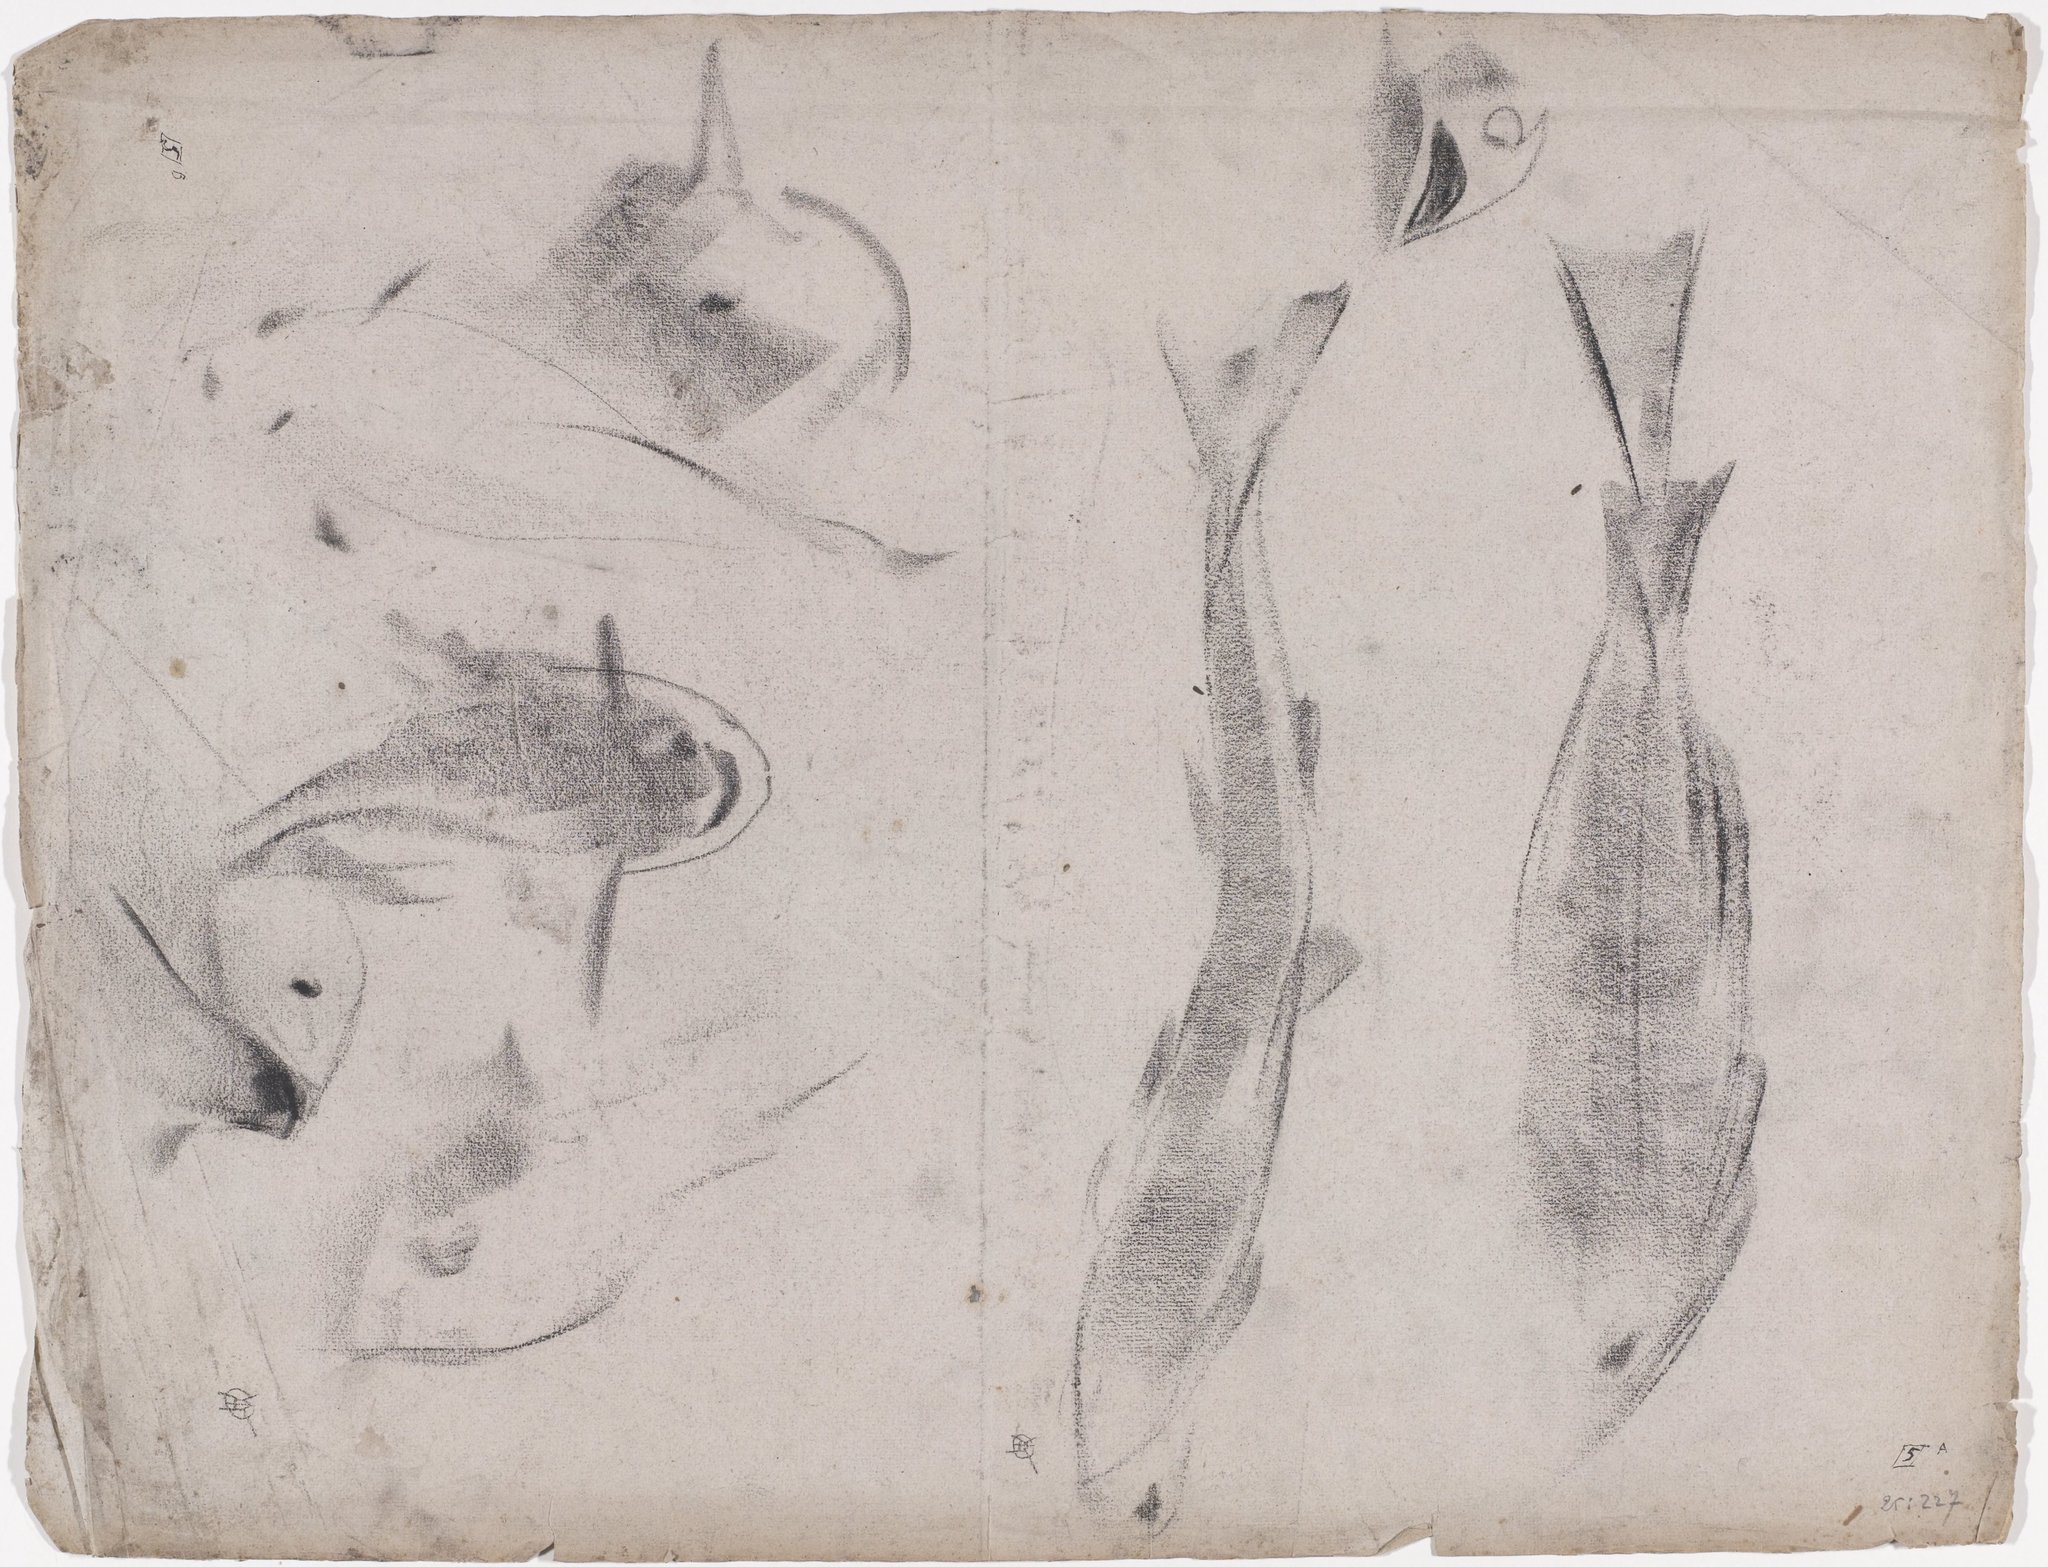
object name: drawing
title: Schetsblad met studies van karpers, van voren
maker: gerrit willem dijsselhof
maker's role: designer, draughtsman, print maker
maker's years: 1866-1924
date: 1876-1924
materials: chalk, paper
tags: fishes